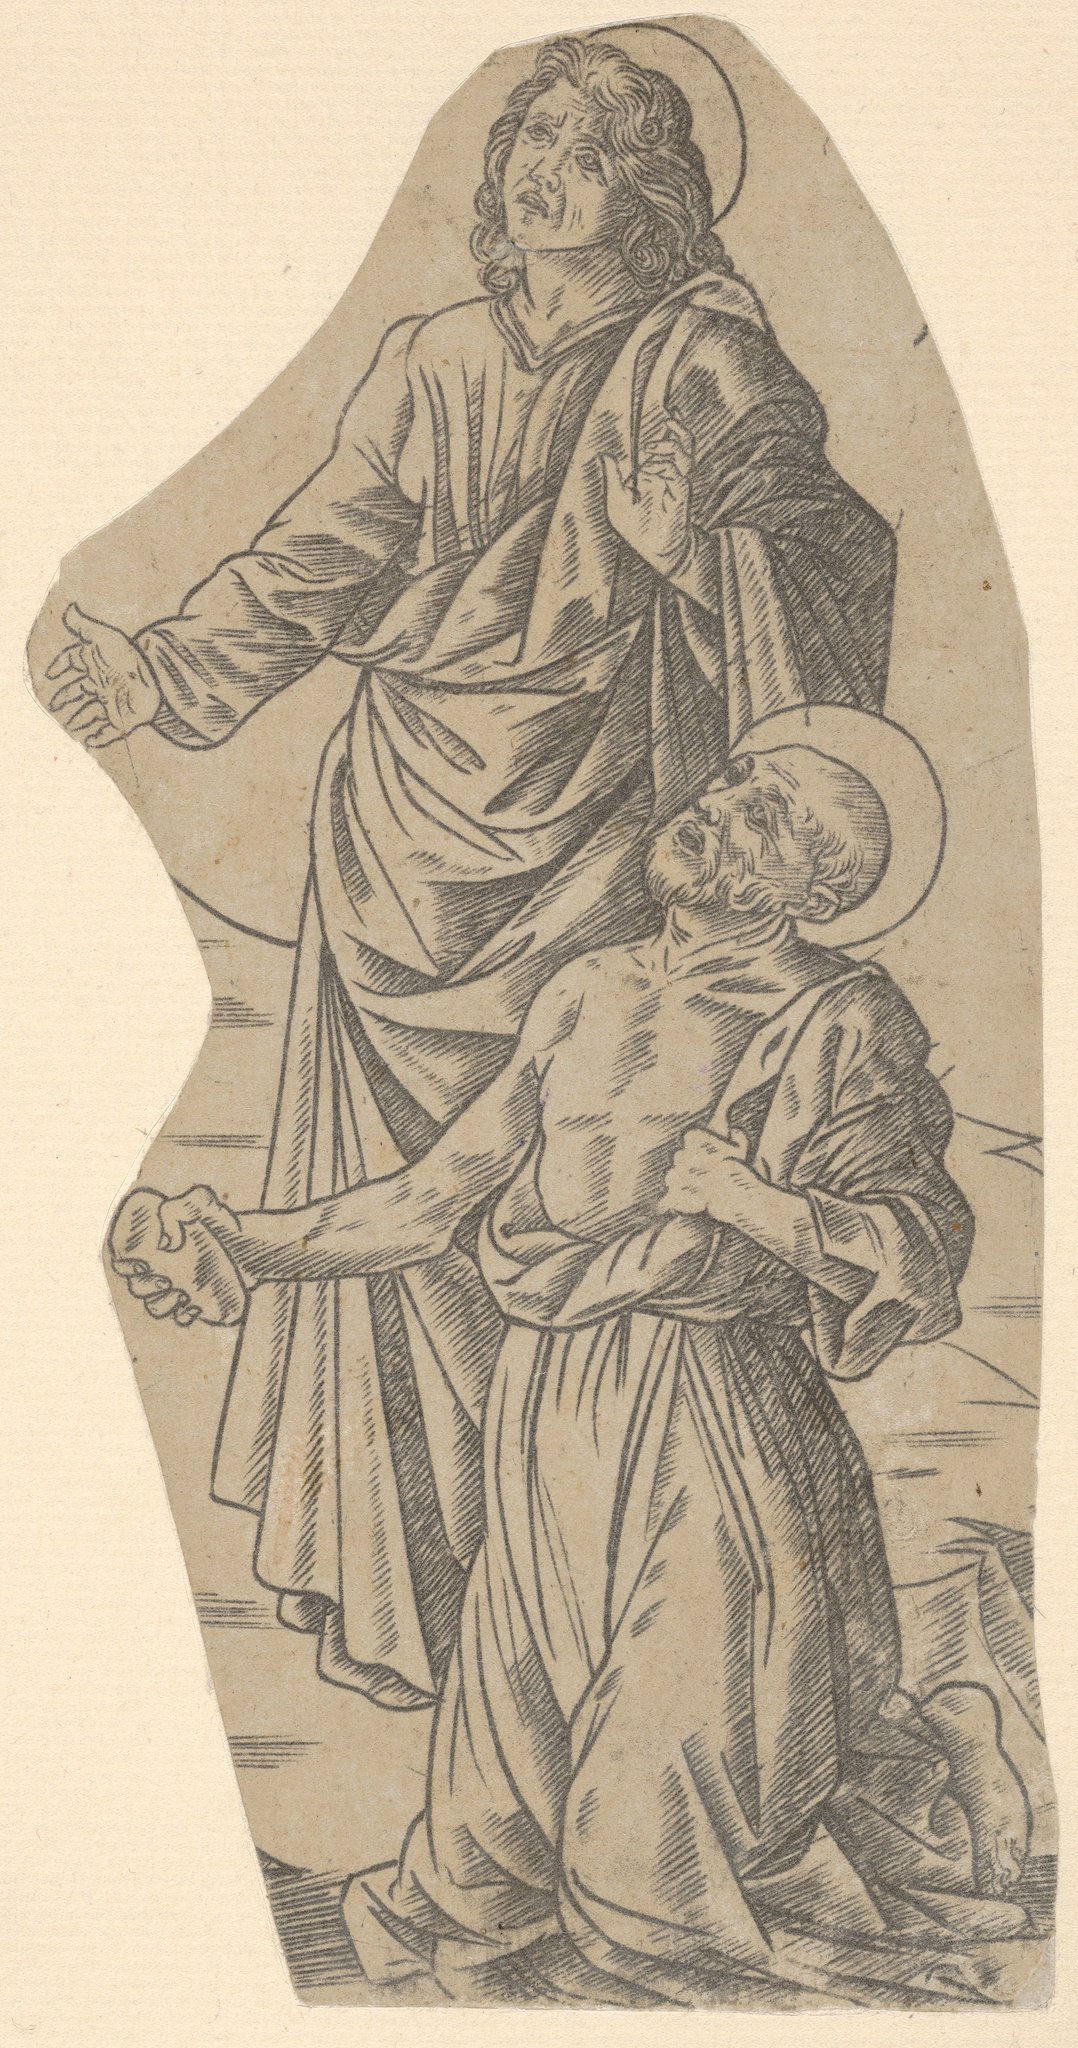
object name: print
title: Saint John and Saint Jerome (fragment from a Crucifixion)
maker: francesco rosselli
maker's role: artist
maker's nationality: italian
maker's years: 1448-1527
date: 1490-1499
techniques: engraving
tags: saint jerome,saint john the baptist